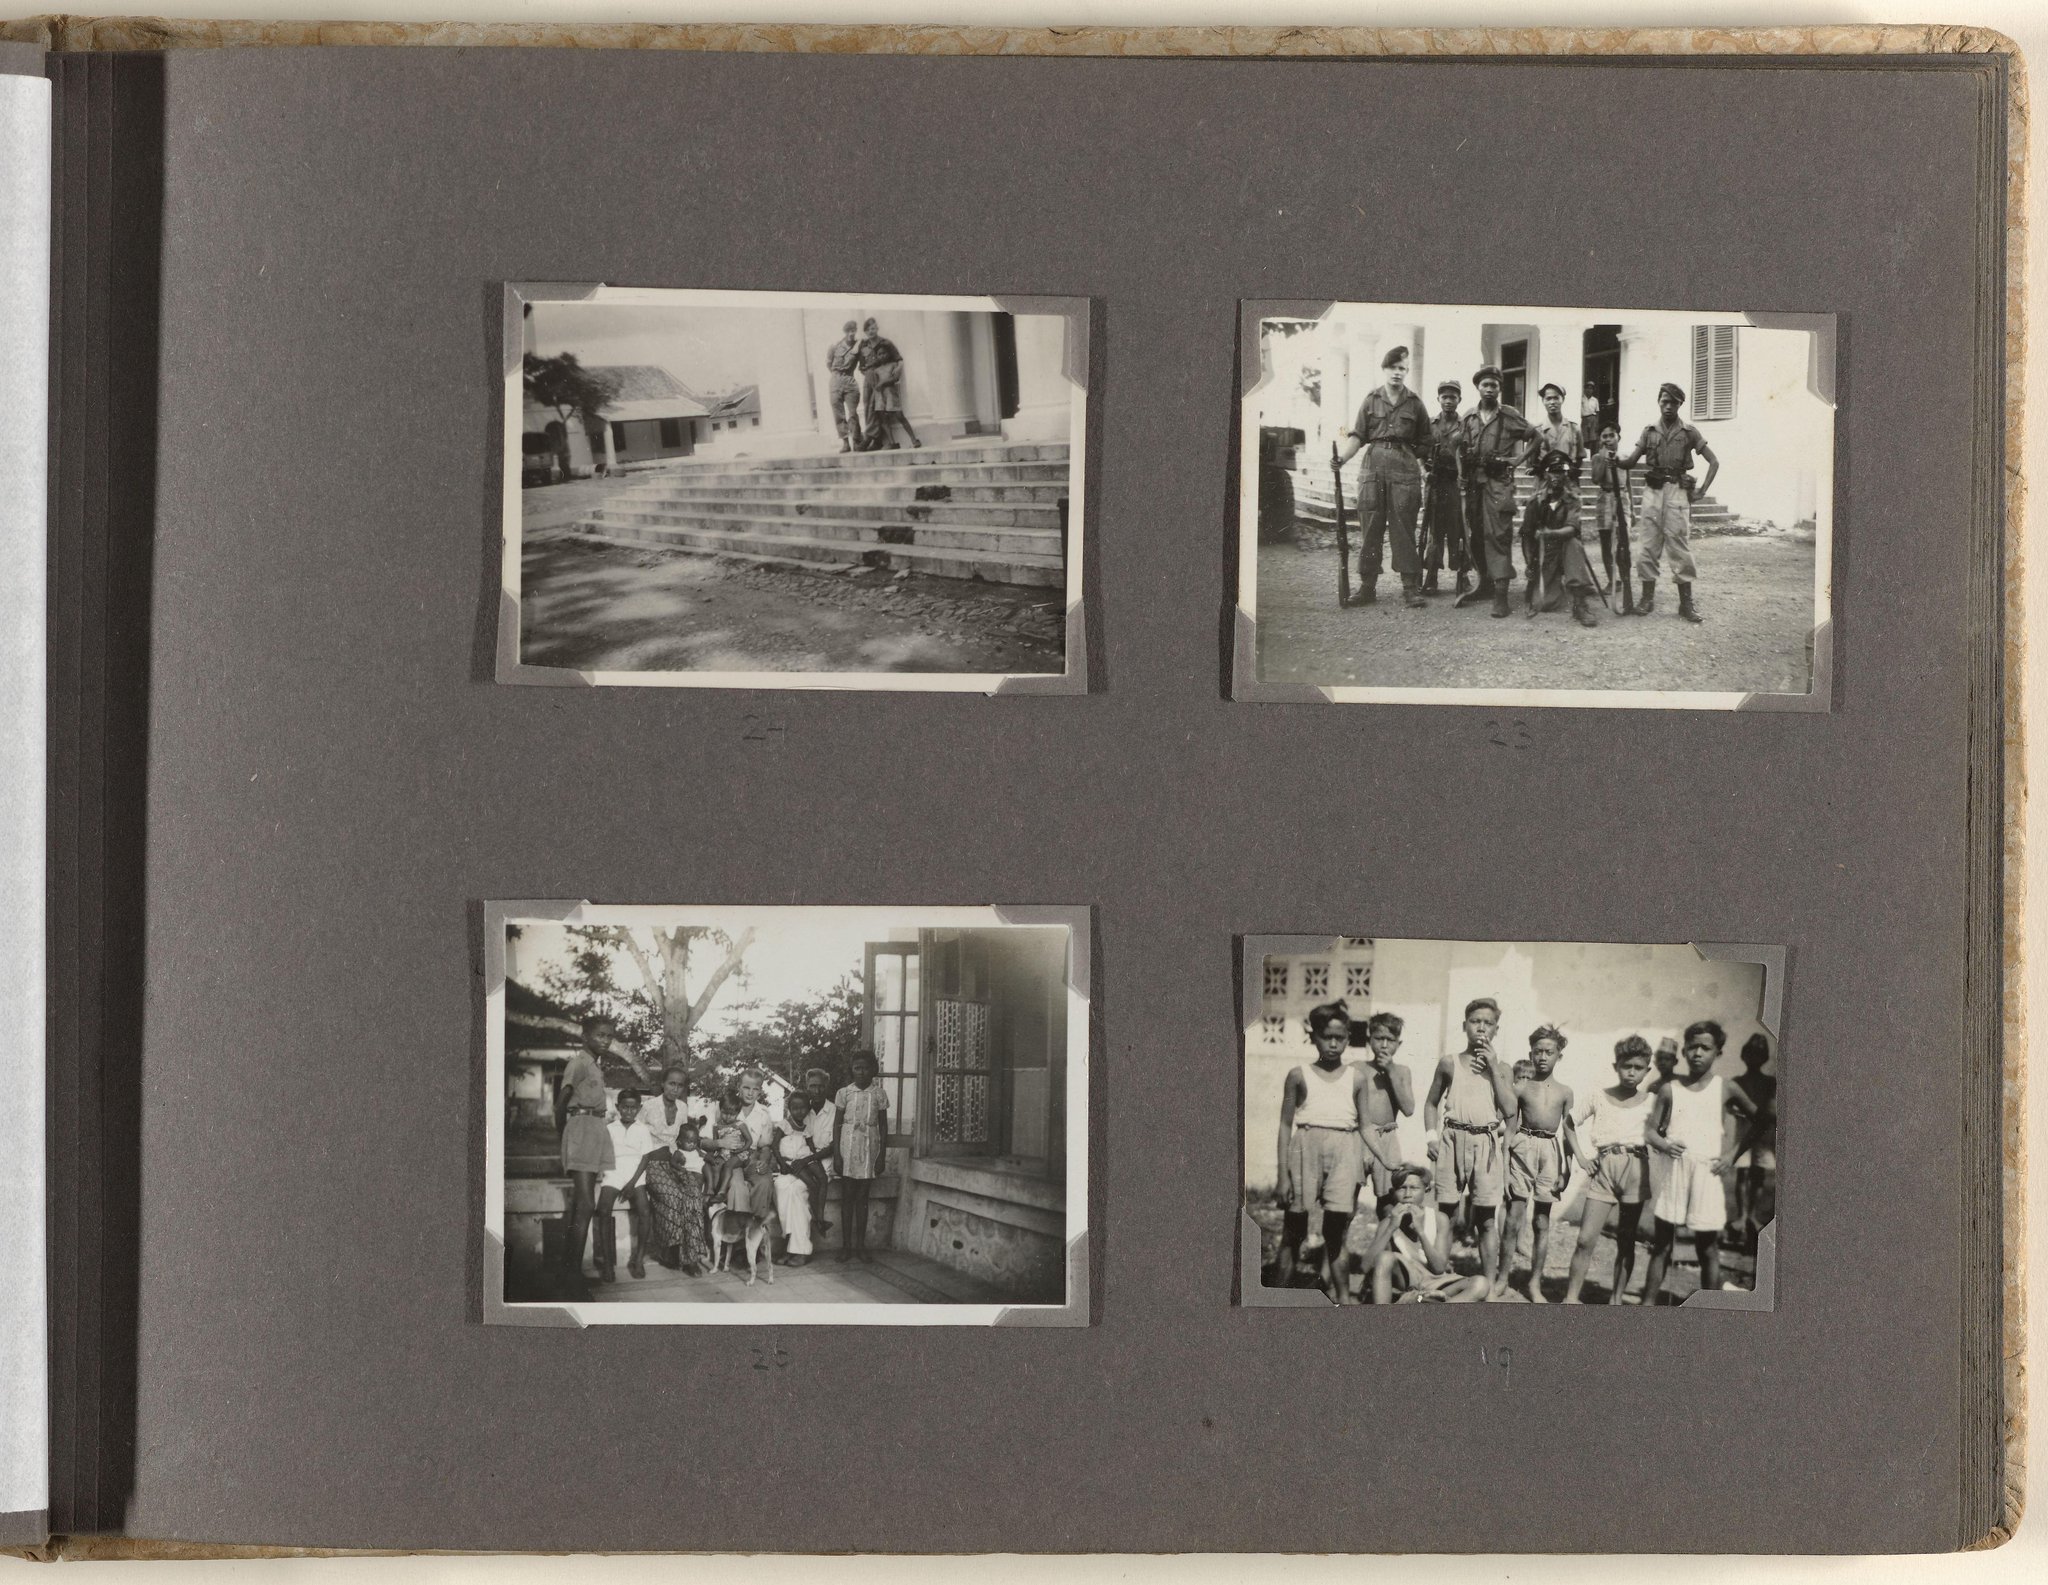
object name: album leaf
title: Militairen en kinderen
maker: Anonymous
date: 1946-1949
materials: cardboard, photographic support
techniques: gelatin silver print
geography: dutch east indies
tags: colonial system, military service, dutch east indies, the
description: Albumblad met vier foto's: groepsportretten van Nederlandse en Indische militairen en enkele groepen kinderen. Onderdeel van het fotoalbum over de diensttijd van Nederlandse militairen in Nederlands-Indië, ca. 1946-1949.